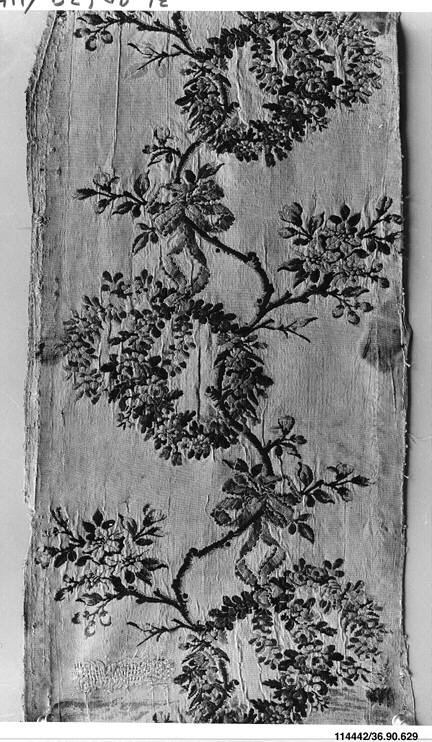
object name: piece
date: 1750-1760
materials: silk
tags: flowers,leaves